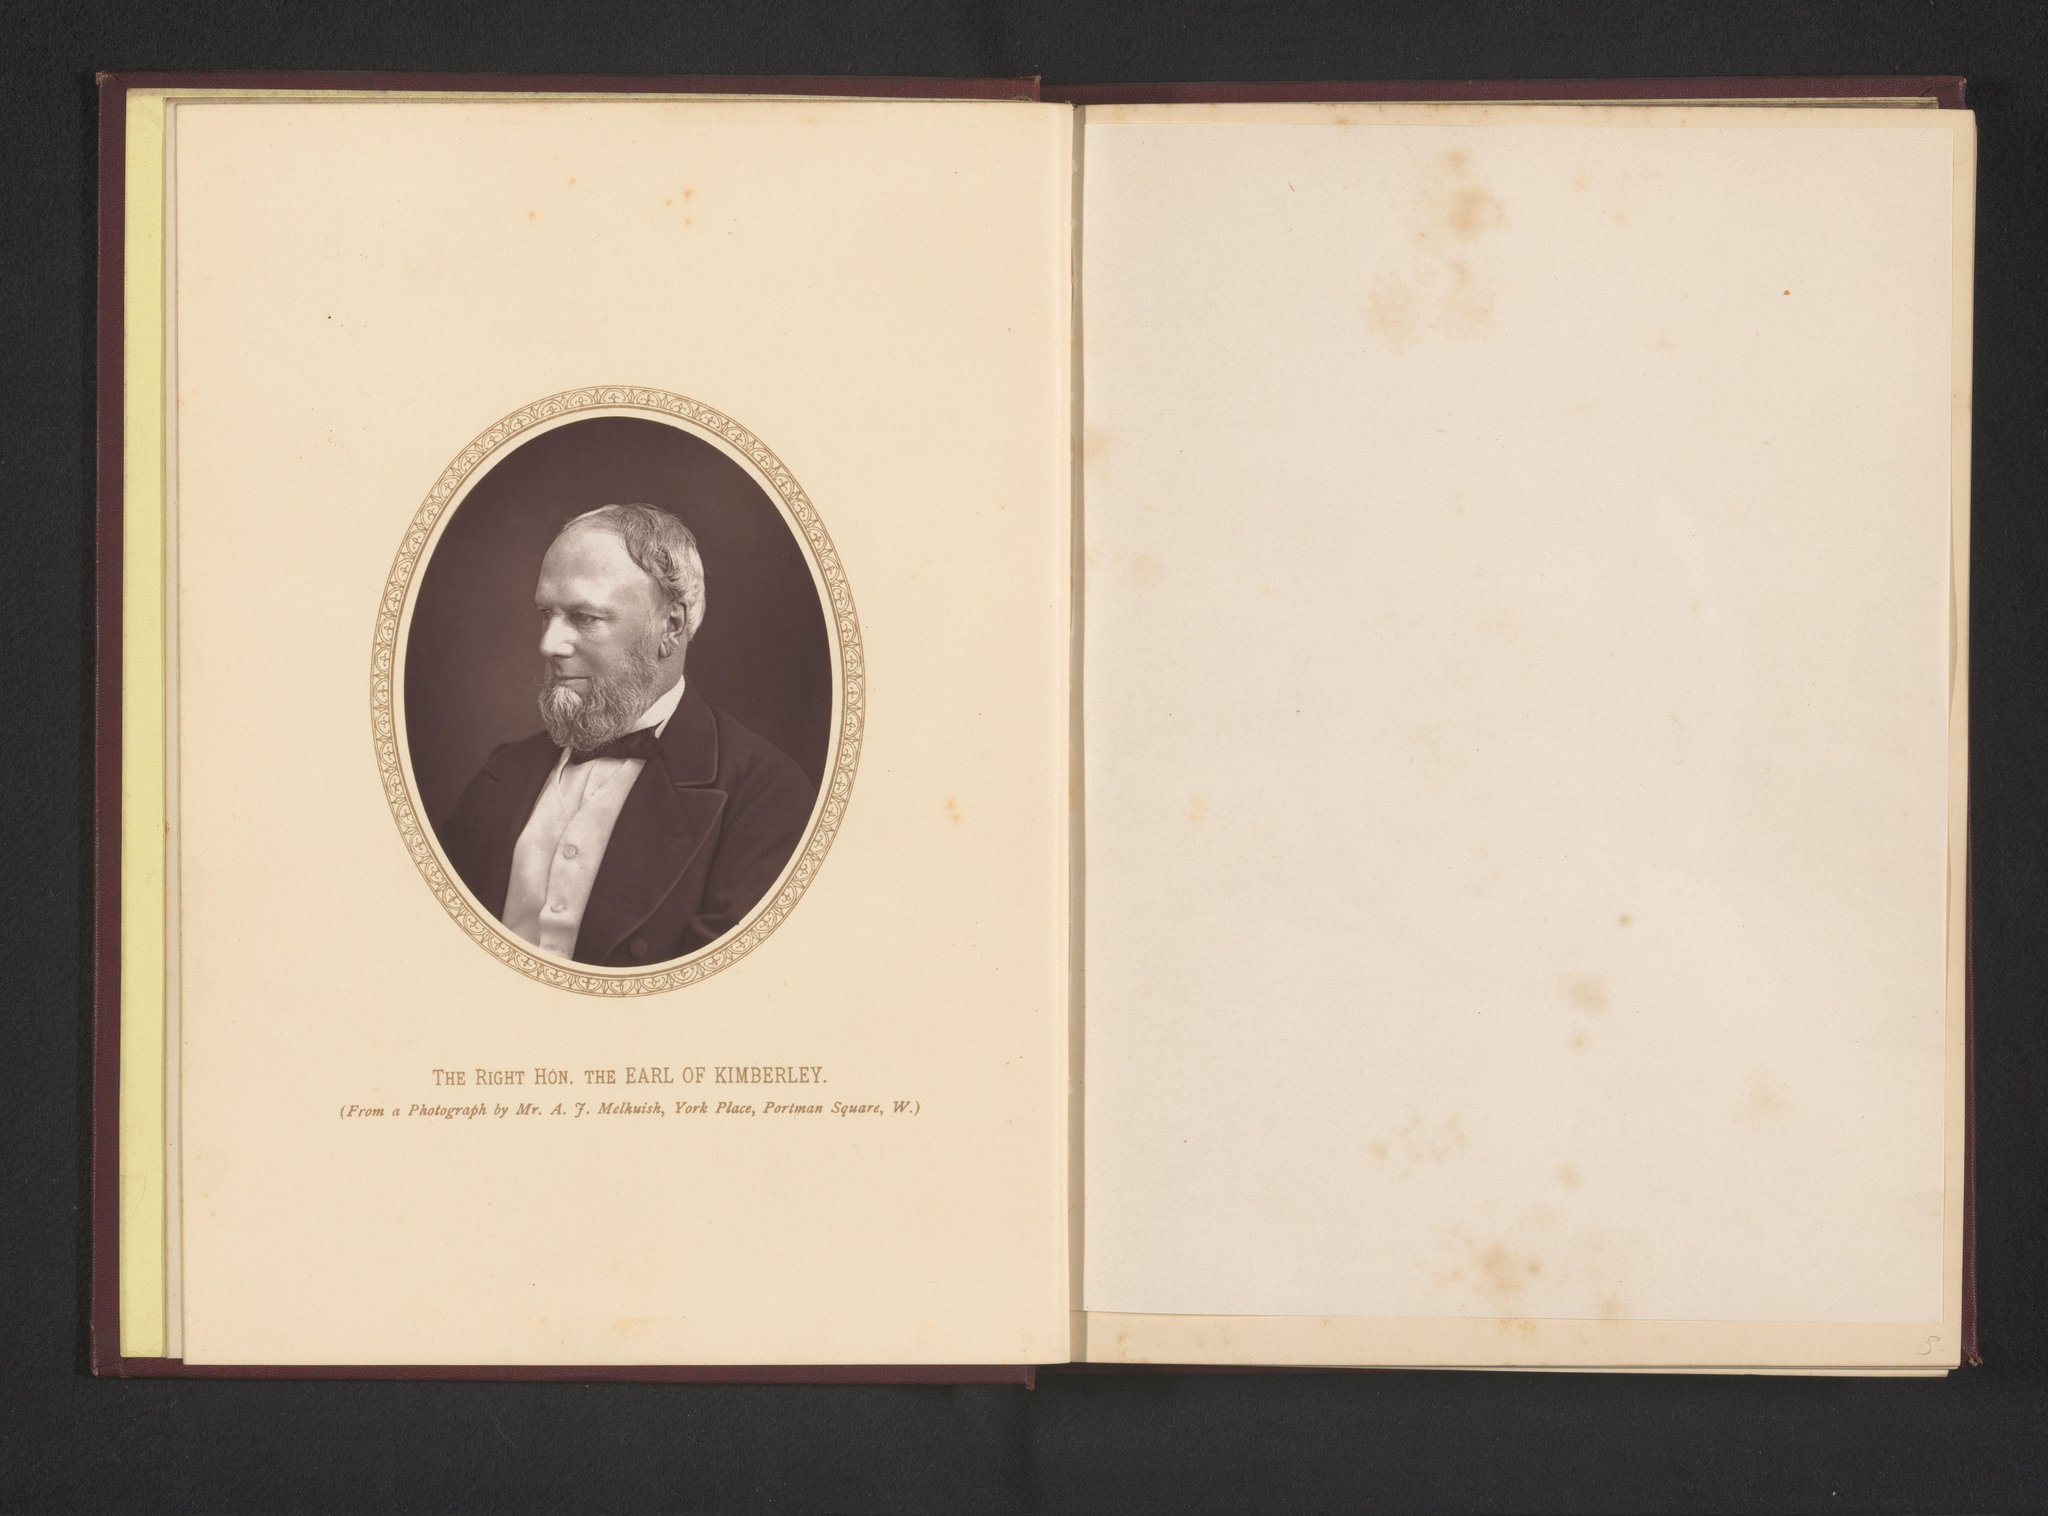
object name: photomechanical print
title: Portret van John Wodehouse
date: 1877-1882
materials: paper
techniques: woodburytype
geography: london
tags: politician, e.g. party leader